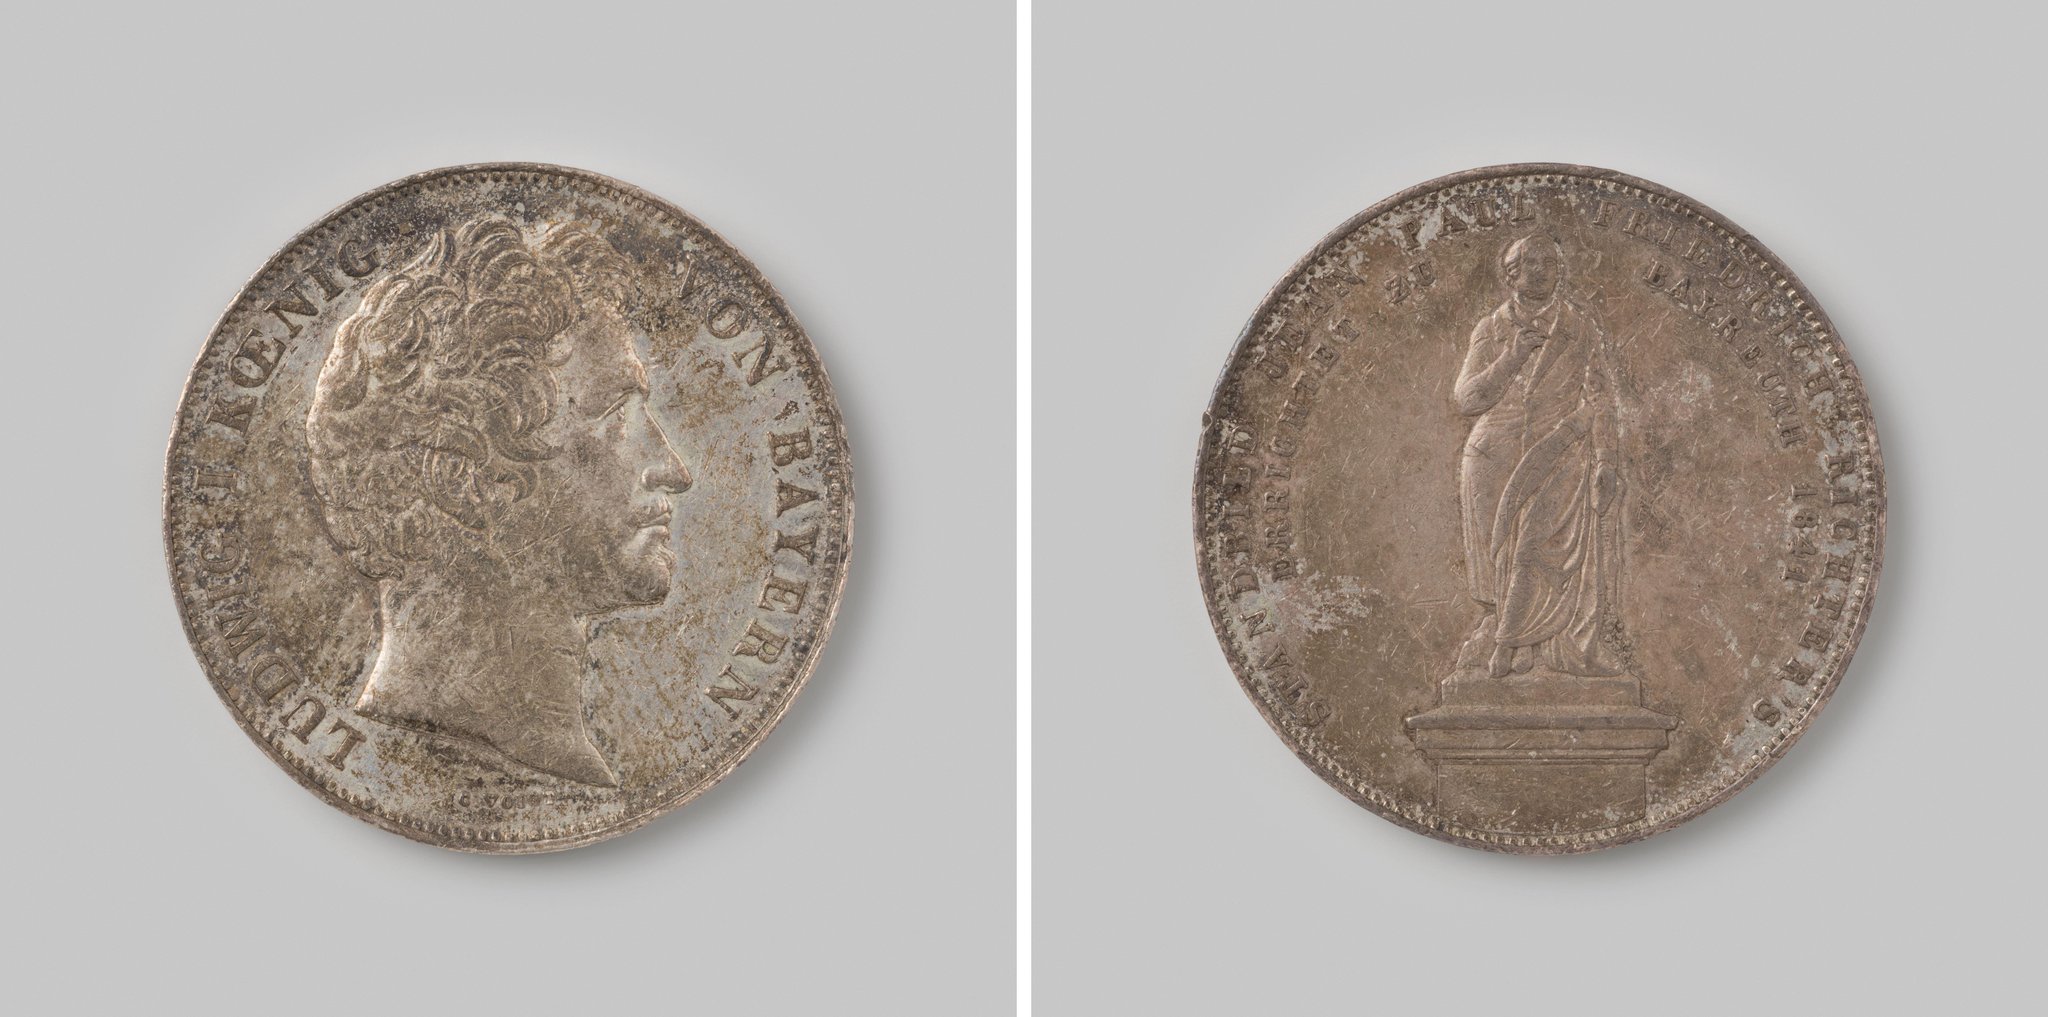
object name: coin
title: Dubbele herdenkingstaler / gedenkdoppeltaler uit het koninkrijk Beieren van Ludwig I, 1841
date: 1841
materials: silver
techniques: striking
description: Zilveren munt. Voorzijde: borstbeeld van de koning naar rechts. Keerzijde: standbeeld van J.P.F. Richter. Dubbel omschrift, waarin jaartal. Randschrift.